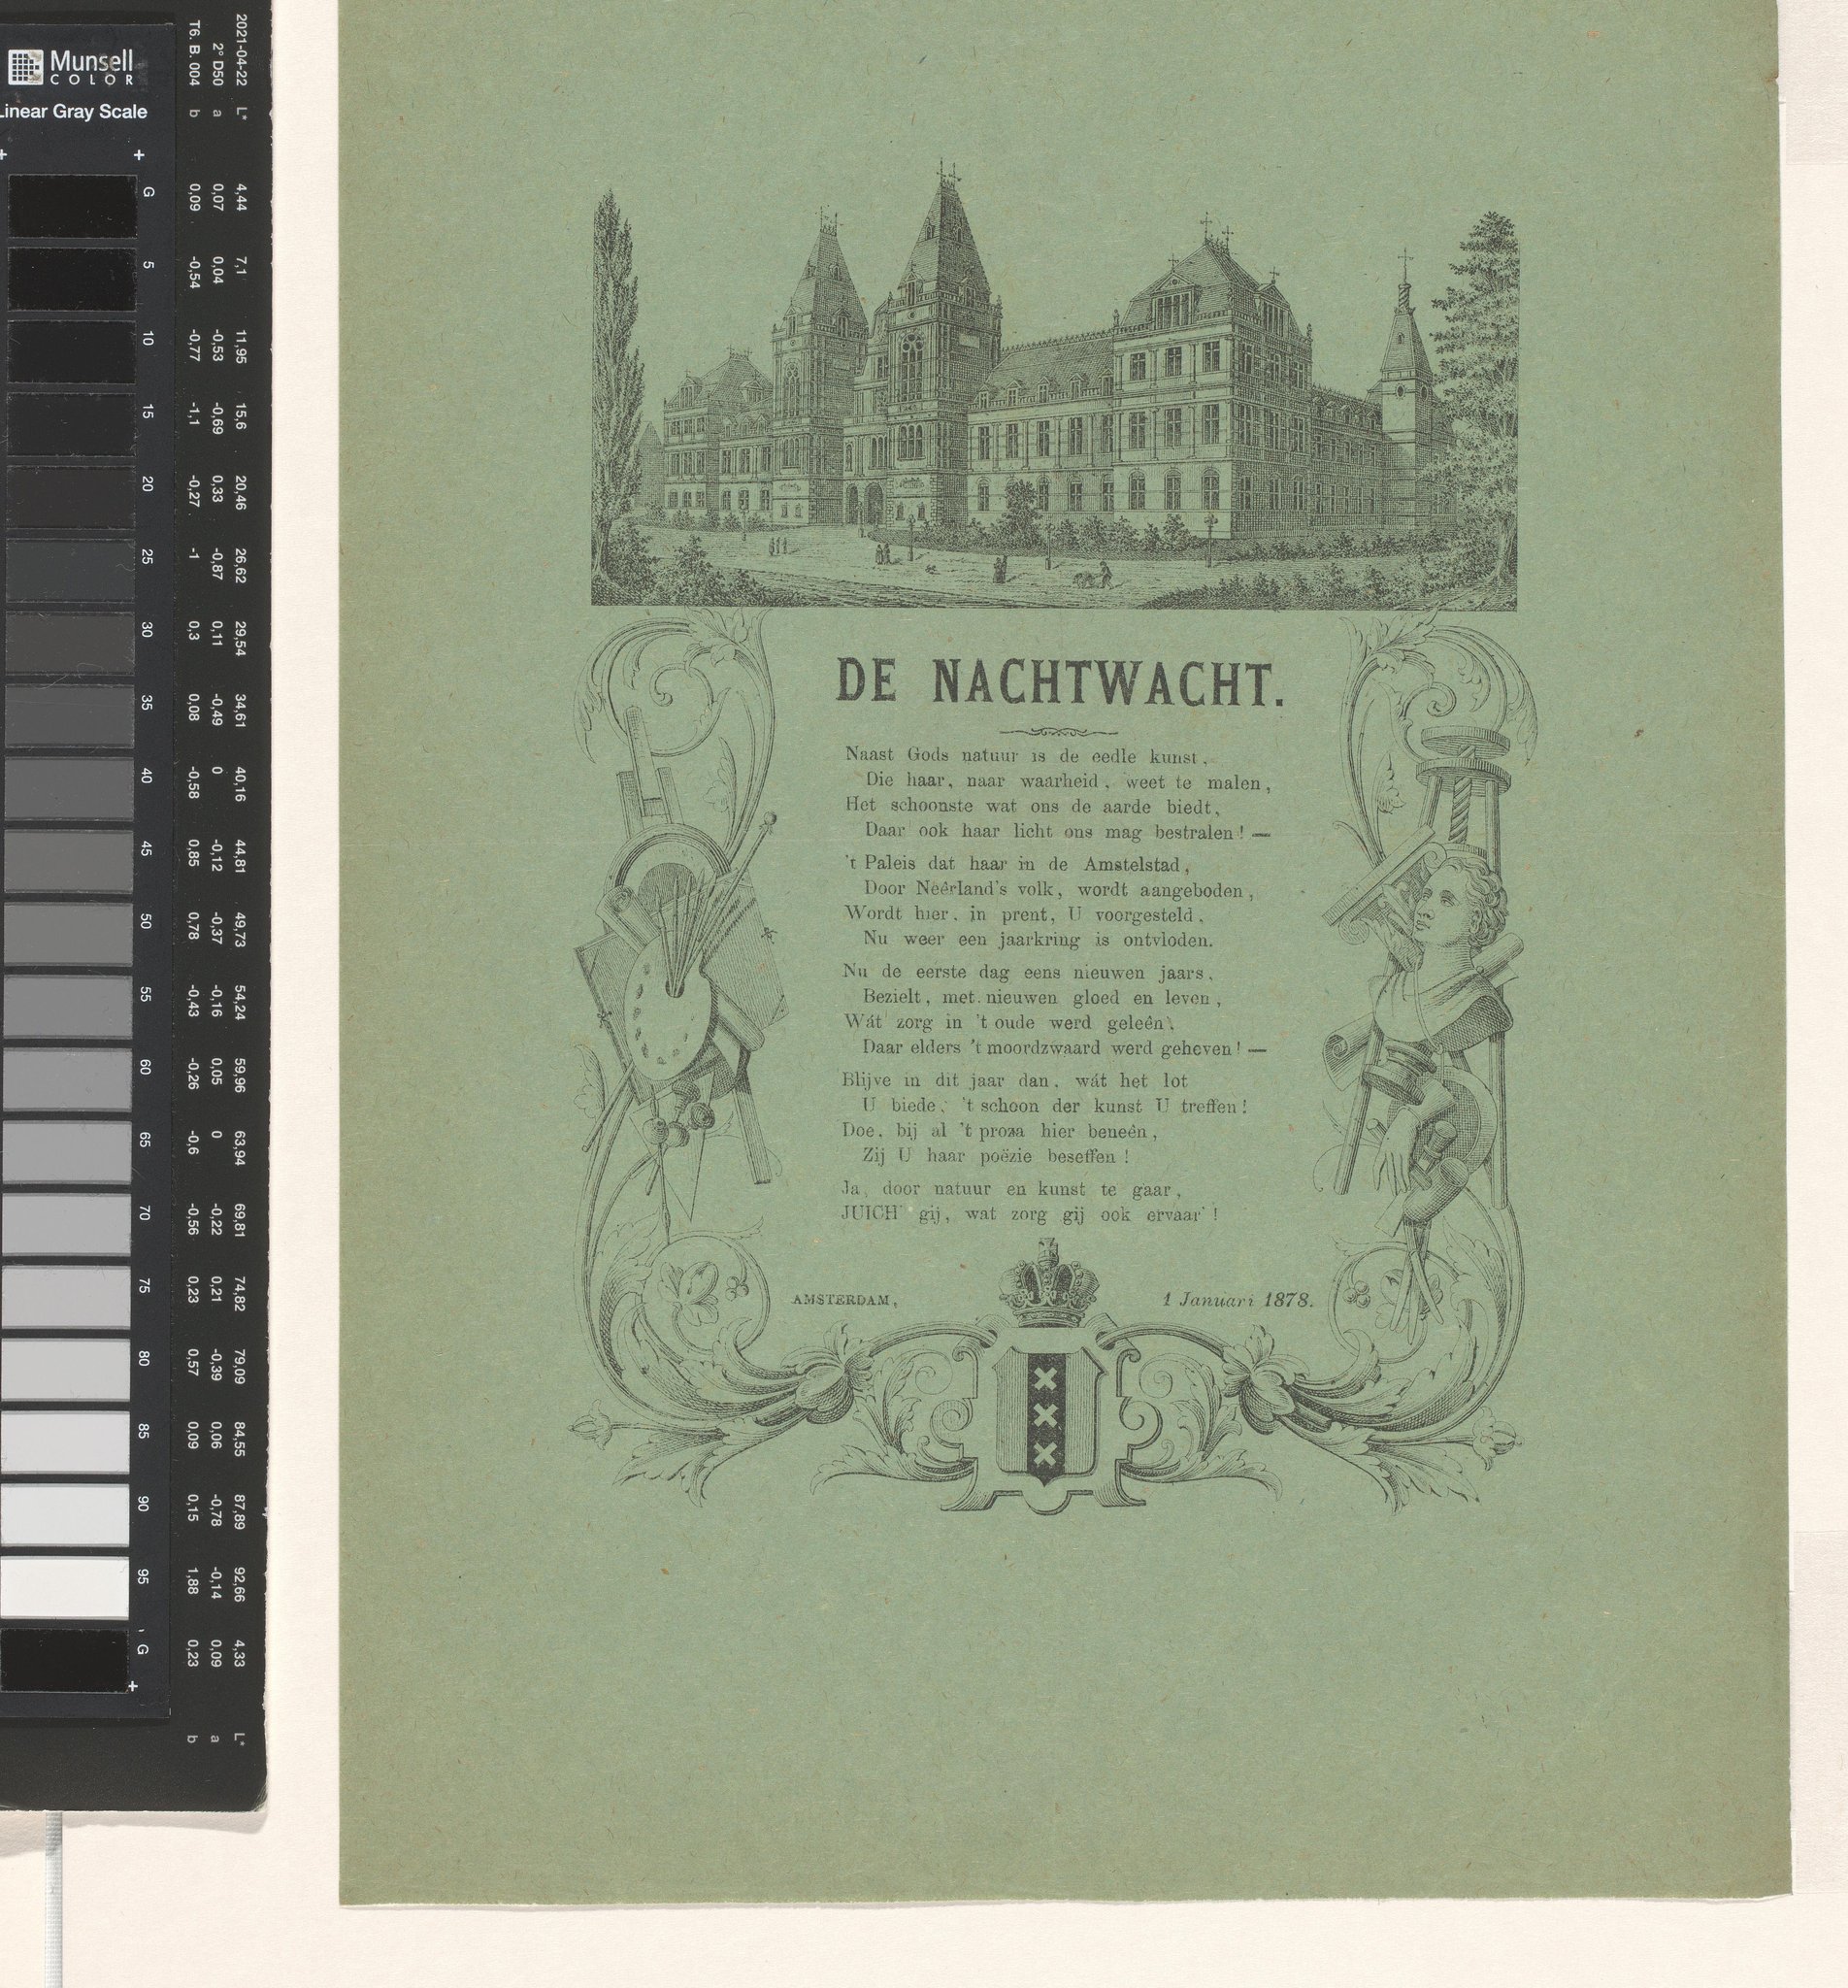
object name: print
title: De Nachtwacht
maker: Anonymous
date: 1877-1878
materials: paper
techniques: lithograph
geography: amsterdam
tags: night patrol, device (as symbol of the state, etc.) (+ city; municipal)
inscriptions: collector's mark: Lugt 2228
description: Nieuwjaarswens van de Amsterdamse nachtwacht (ratelwacht) voor het jaar 1878. Centraal een gedicht, met daarboven als afbeelding een presentatietekening van het te bouwen Rijksmuseum naar ontwerp van Cuypers. Om het gedicht een gedecoreerde lijst met het wapen van Amsterdam en referenties aan de beeldende kunsten.